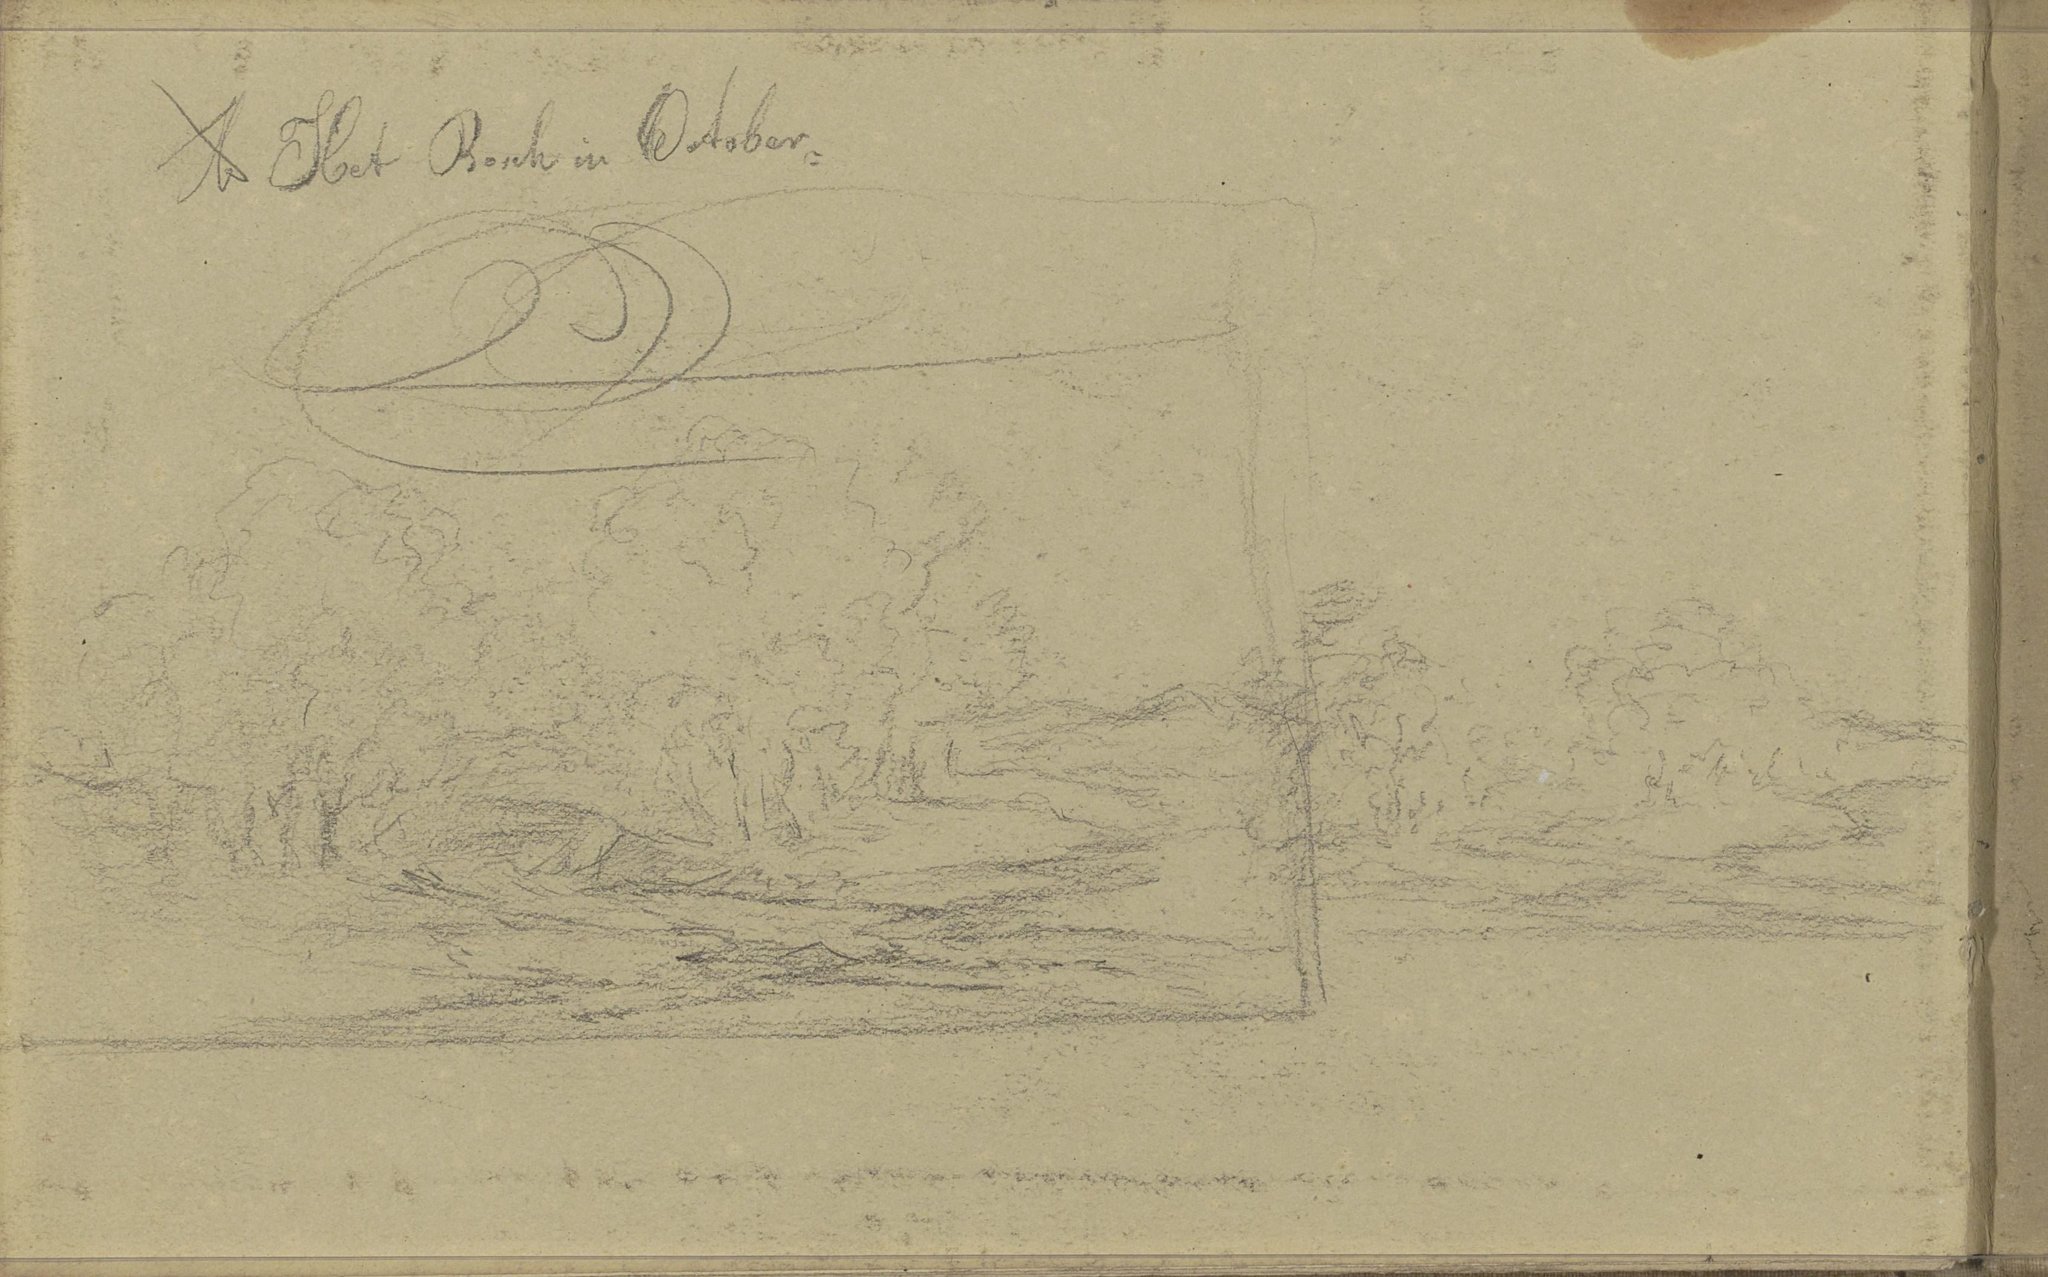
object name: sketchbook leaf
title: Rand van een bos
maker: willem cornelis rip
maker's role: draughtsman, painter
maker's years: 1856-1922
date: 1810-1874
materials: paper, pencil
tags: fringe, edge of the wood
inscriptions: date and inscription: ‘[...] Het Bosch in October’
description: Blad 47 verso uit een schetsboek met 47 bladen.